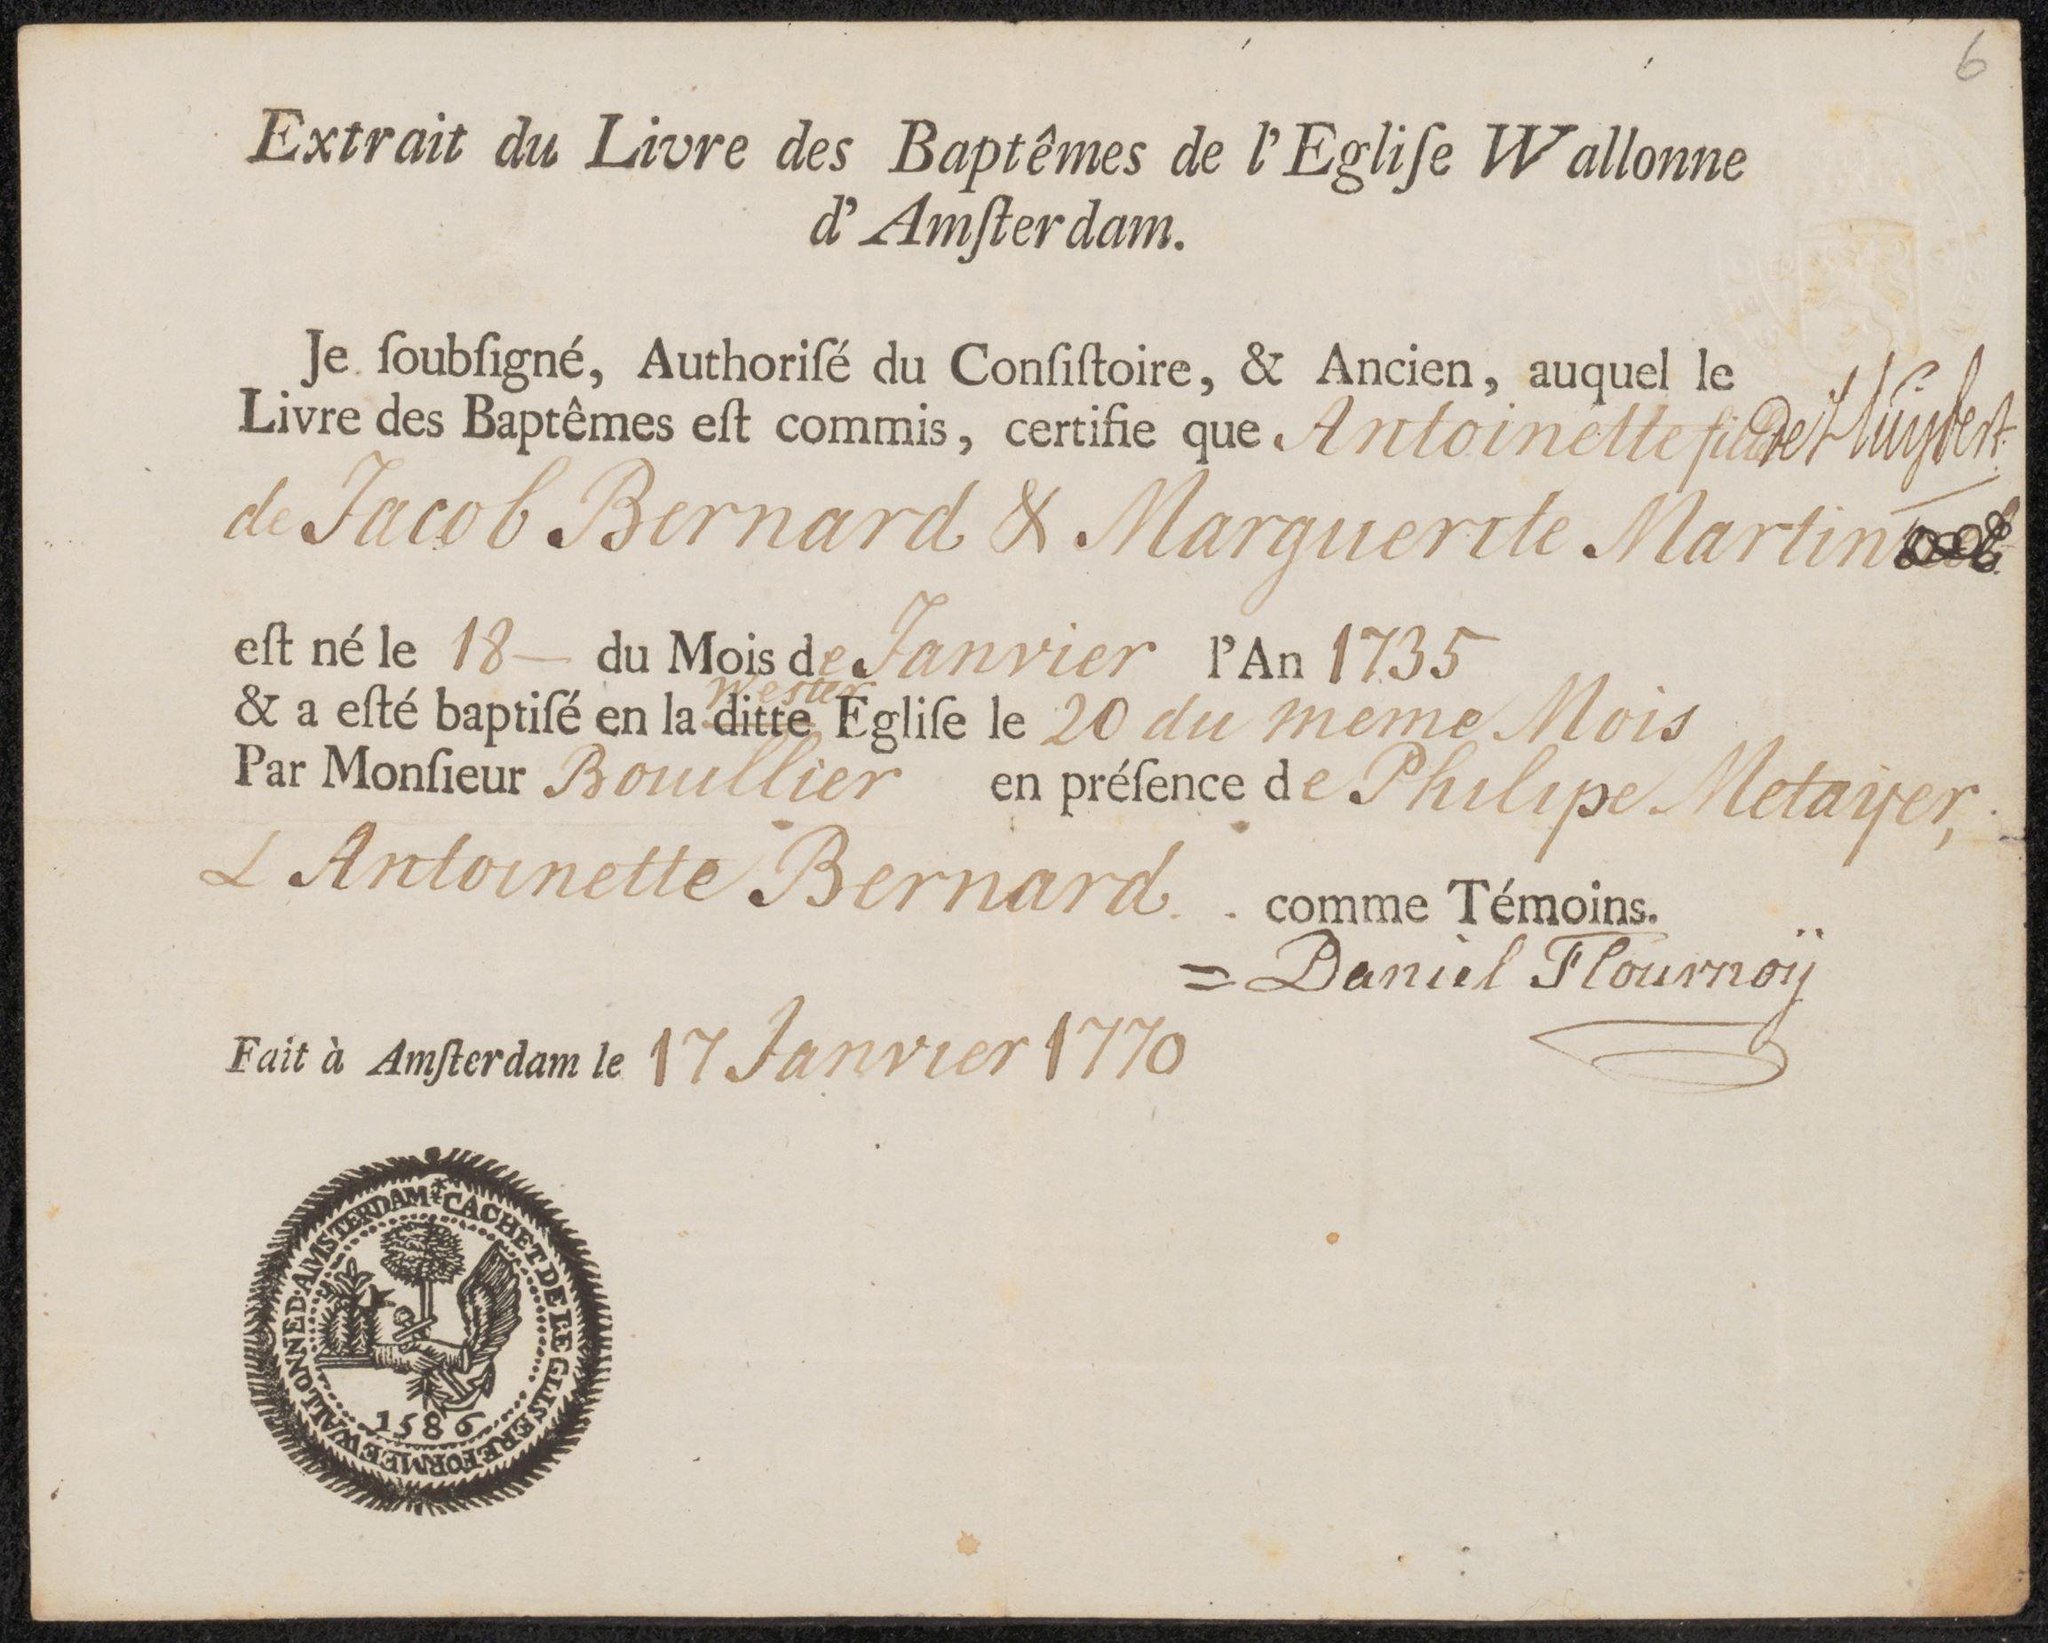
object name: document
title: Uittreksel uit doopregister betreffende Antoinette Bernard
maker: Anonymous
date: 1770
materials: ink, paper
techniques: pen, printing, writing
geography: amsterdam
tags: antoinette bernard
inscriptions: watermark, stamp: ‘CLEIN SEGEL 1768’, collector's mark: Lugt 2233